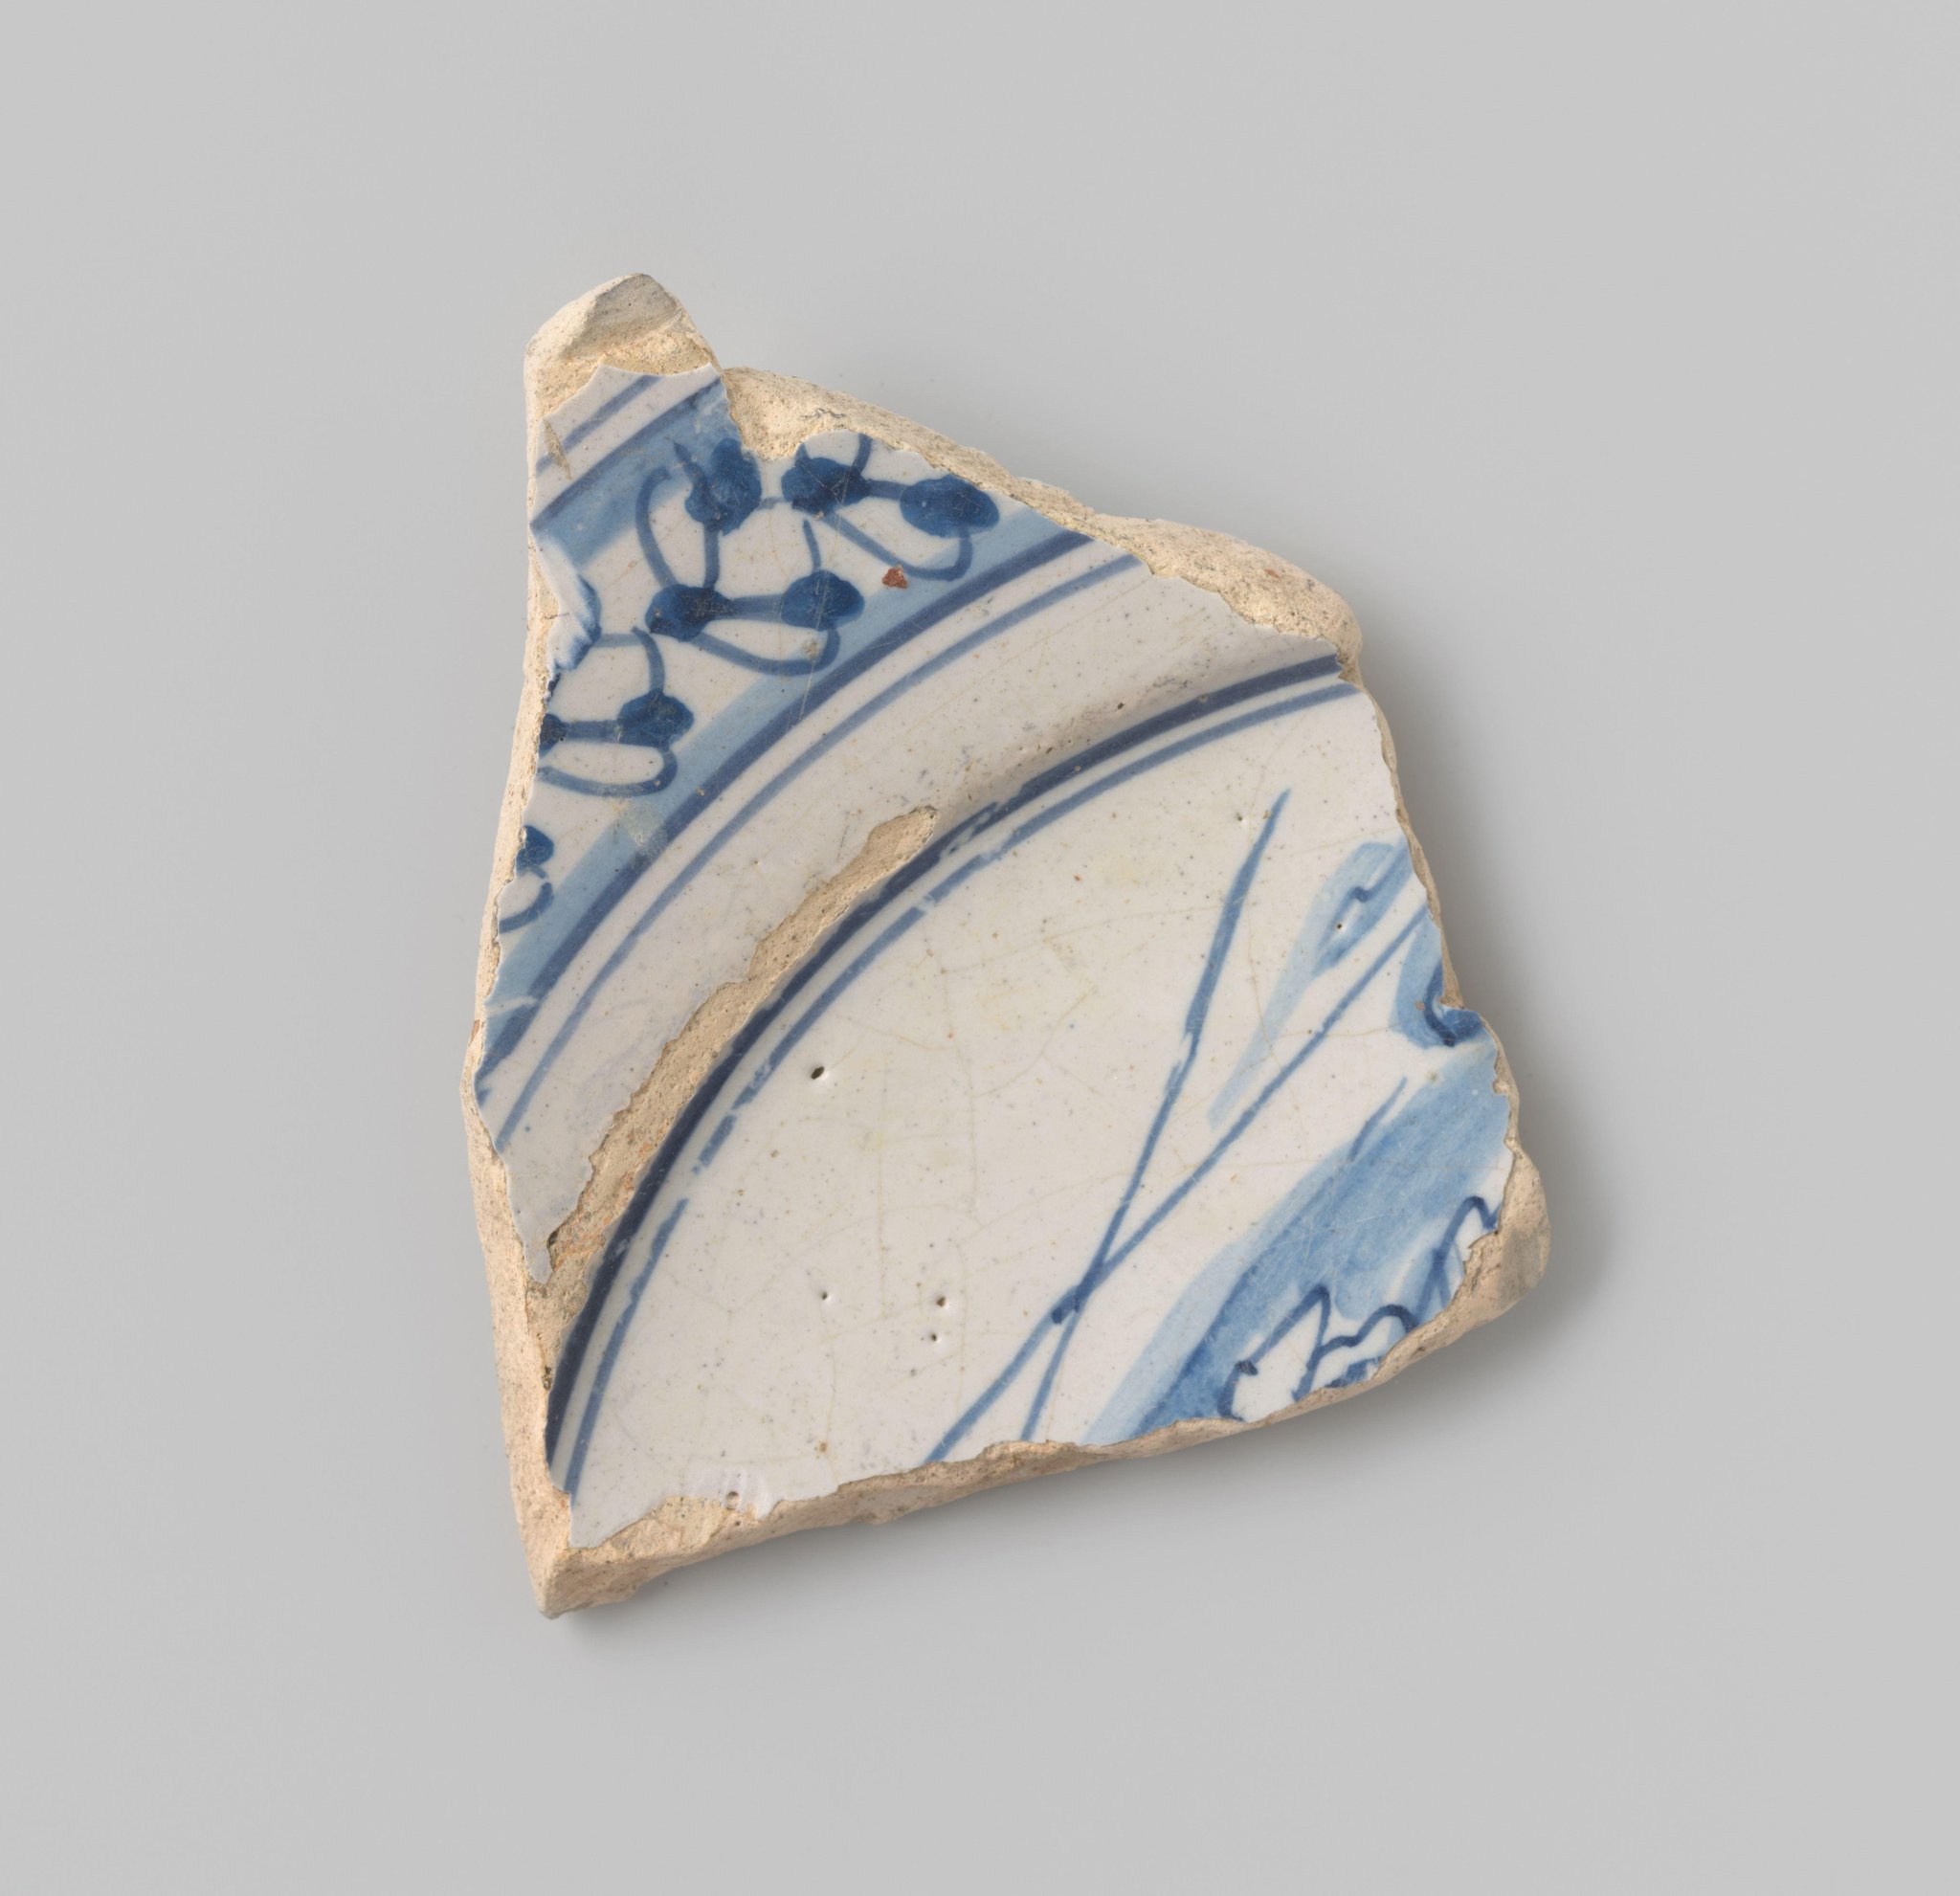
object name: fragment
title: Schotelscherf van witbakkend aardewerk, voorzien van wit glazuur aan de boven- en onderzijde, waarbij op de bovenzijde de resten van een omrande voorstelling in blauw te zien zijn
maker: Anonymous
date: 1500-1699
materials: earthenware, glaze